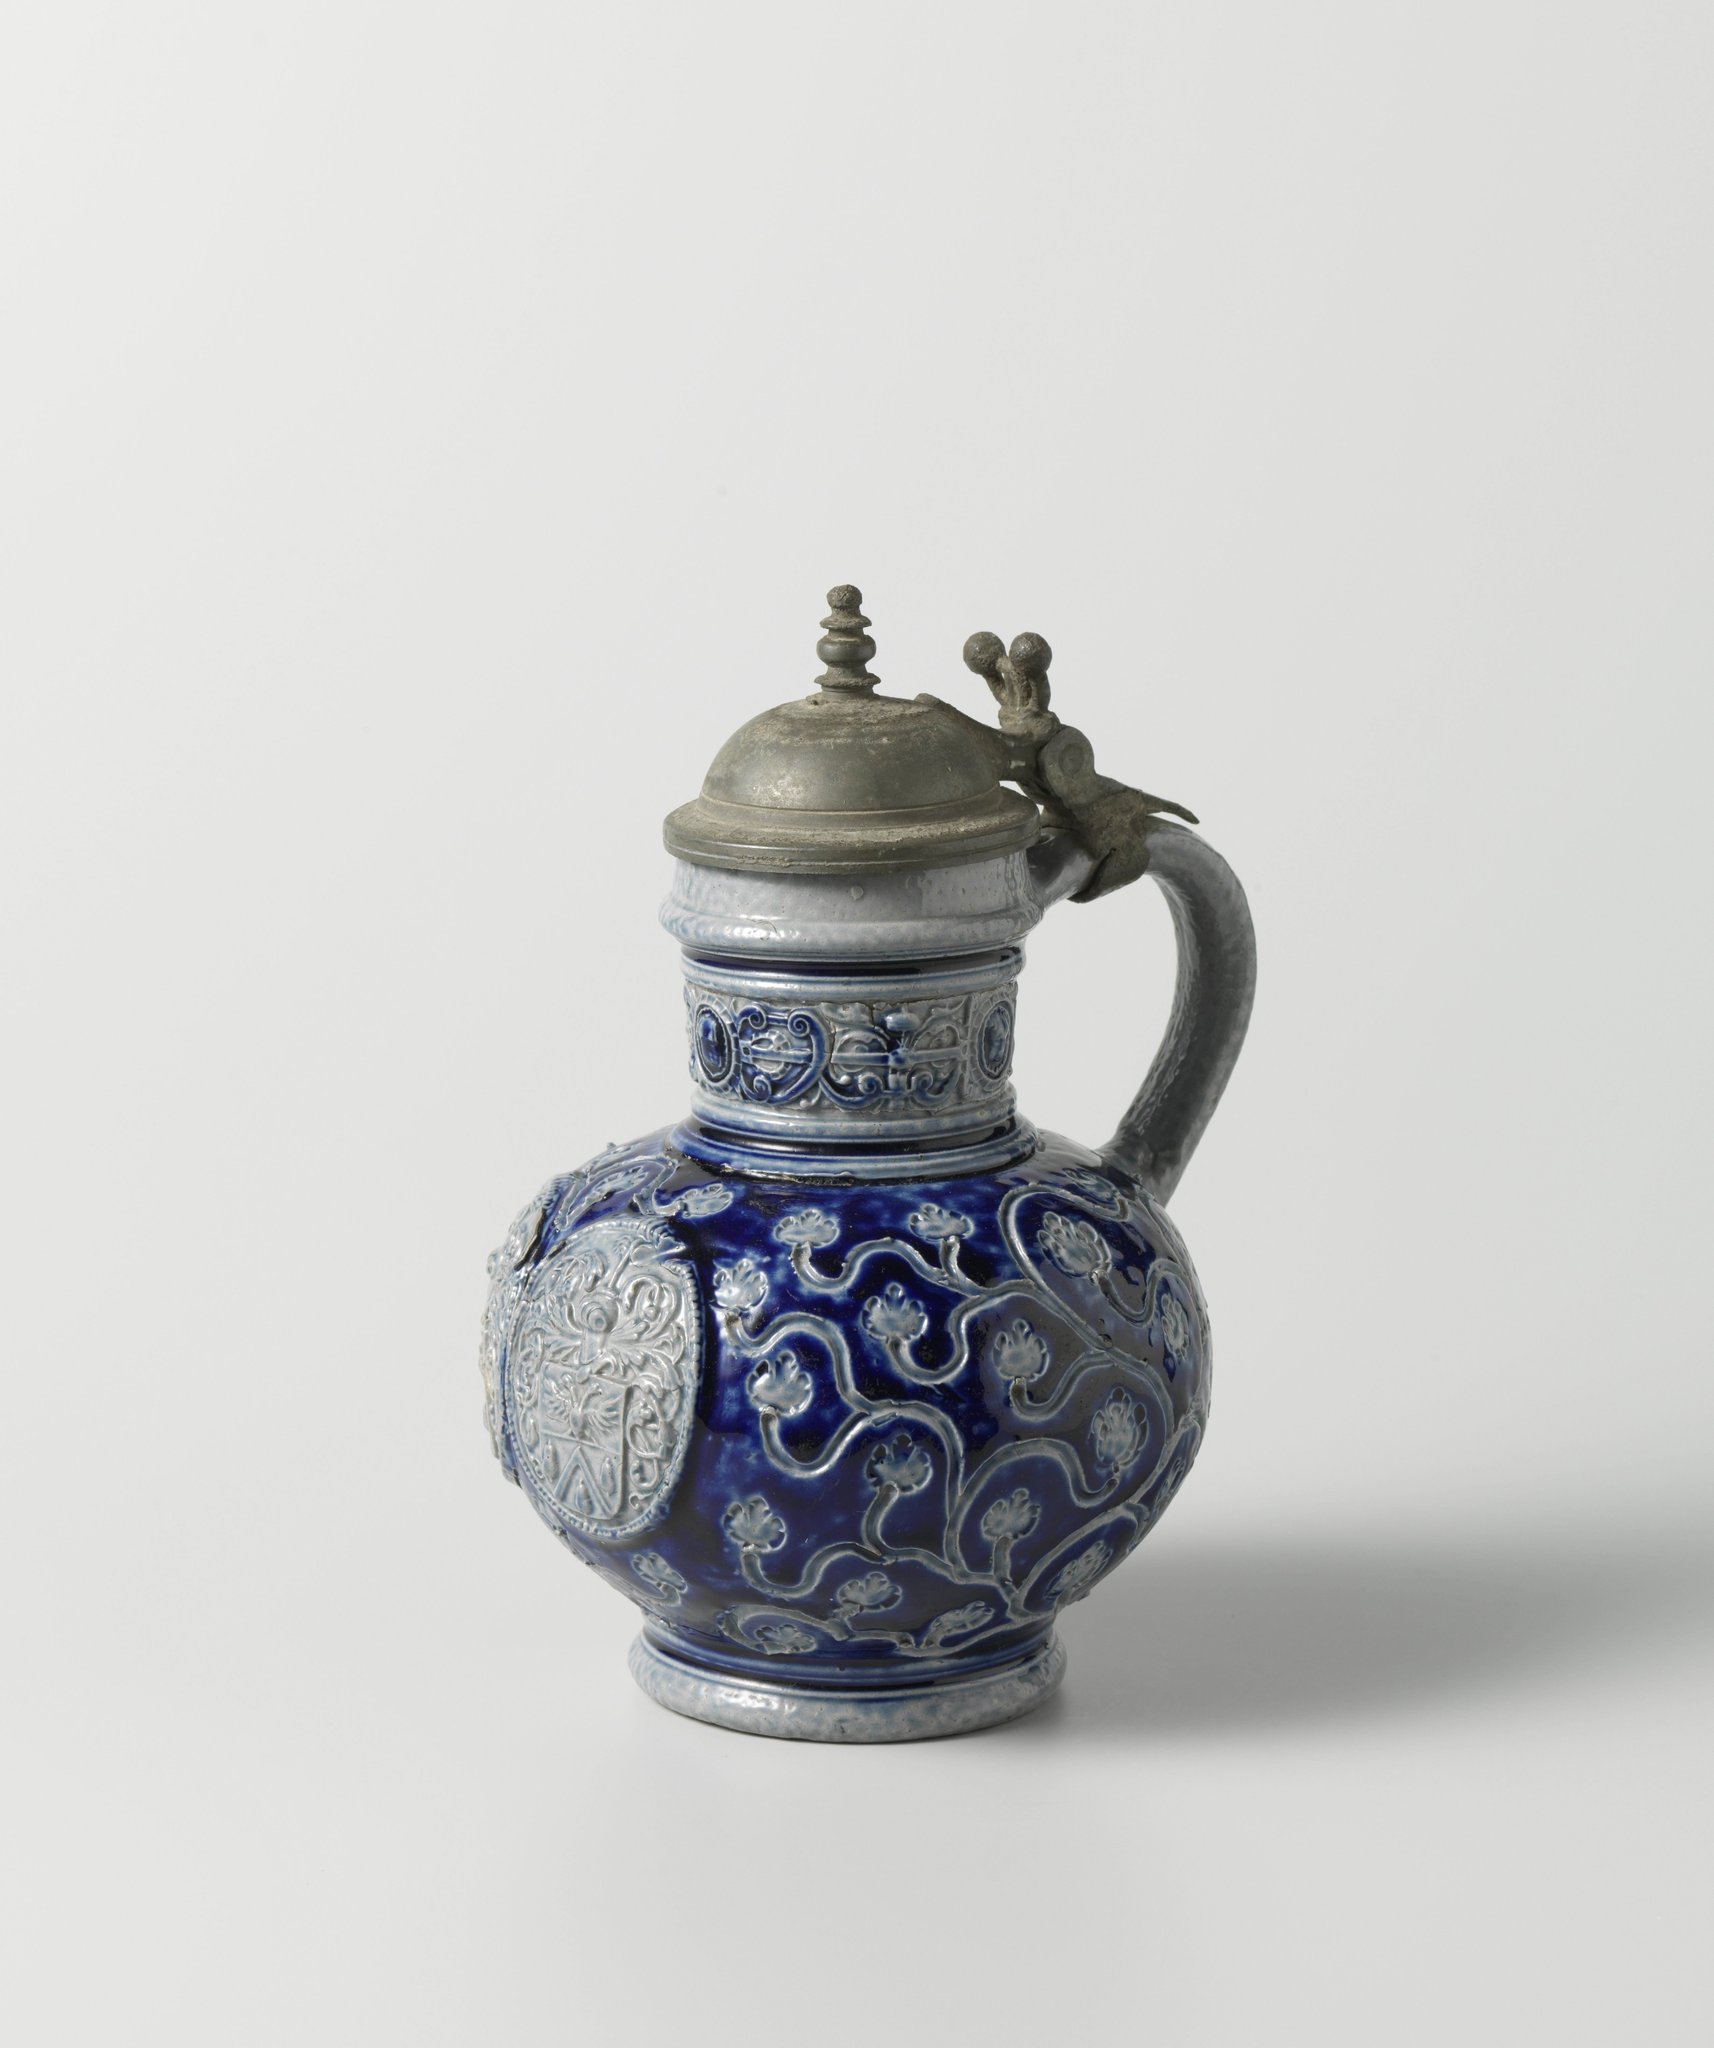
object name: jug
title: Jug with a coat of arms and floral scrolls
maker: Anonymous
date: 1595-1625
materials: cobalt, glaze, stoneware, tin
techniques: printing, firing, forming, relief, turning, vitrification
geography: raeren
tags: armorial bearing, heraldry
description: Kruik van steengoed op standring met een bolvormige buik en wijde nek. Het C-vormige oor is bevestigd aan de nek en de schouder. Profielen op de nek en de voet. Gedeeltelijk bedekt met kobaltblauw. Op de buik in reliëf tweemaal een gedrukt en opgelegd wapen tussen ingegrifte ranken met gestempelde bloemen. Op de nek een band met rolwerk onderbroken door medaillons met een masker. Bevestigd aan het oor een tinnen montuur met deksel. Raeren.